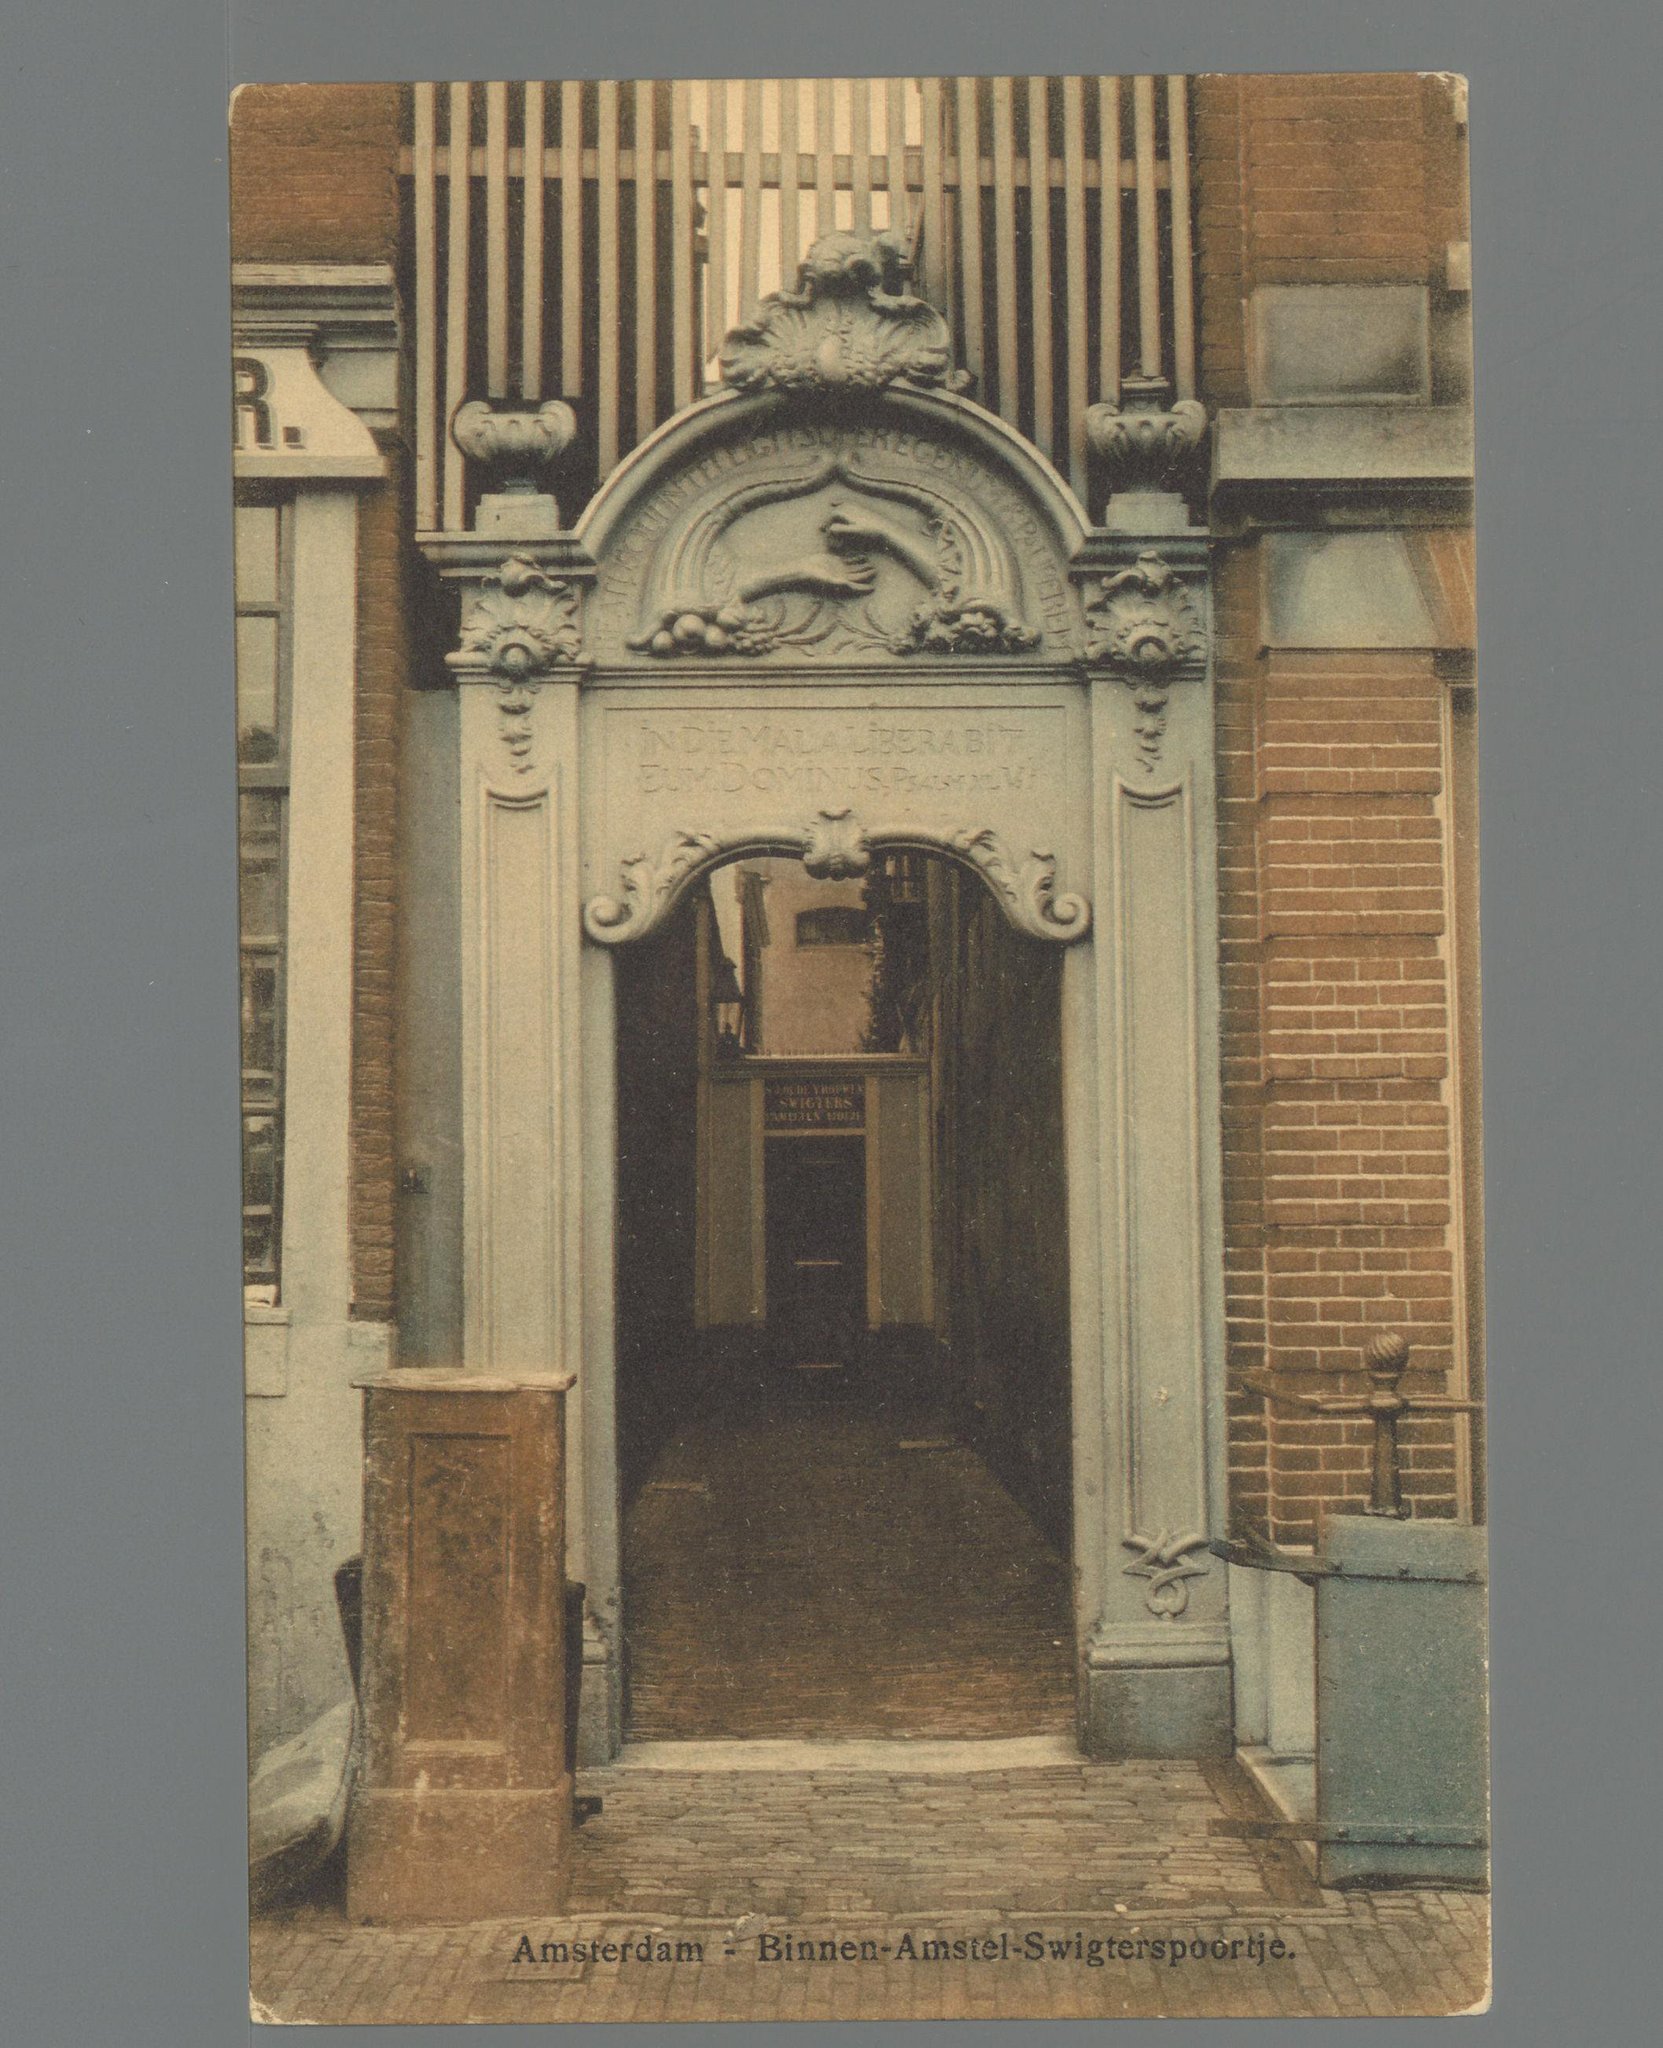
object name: ansichtkaart, prentbriefkaart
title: Amsterdam - Binnen-Amstel-Swigterspoortje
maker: Anonymous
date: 1910-1912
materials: cardboard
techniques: collotype process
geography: amsterdam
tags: gate, entrance